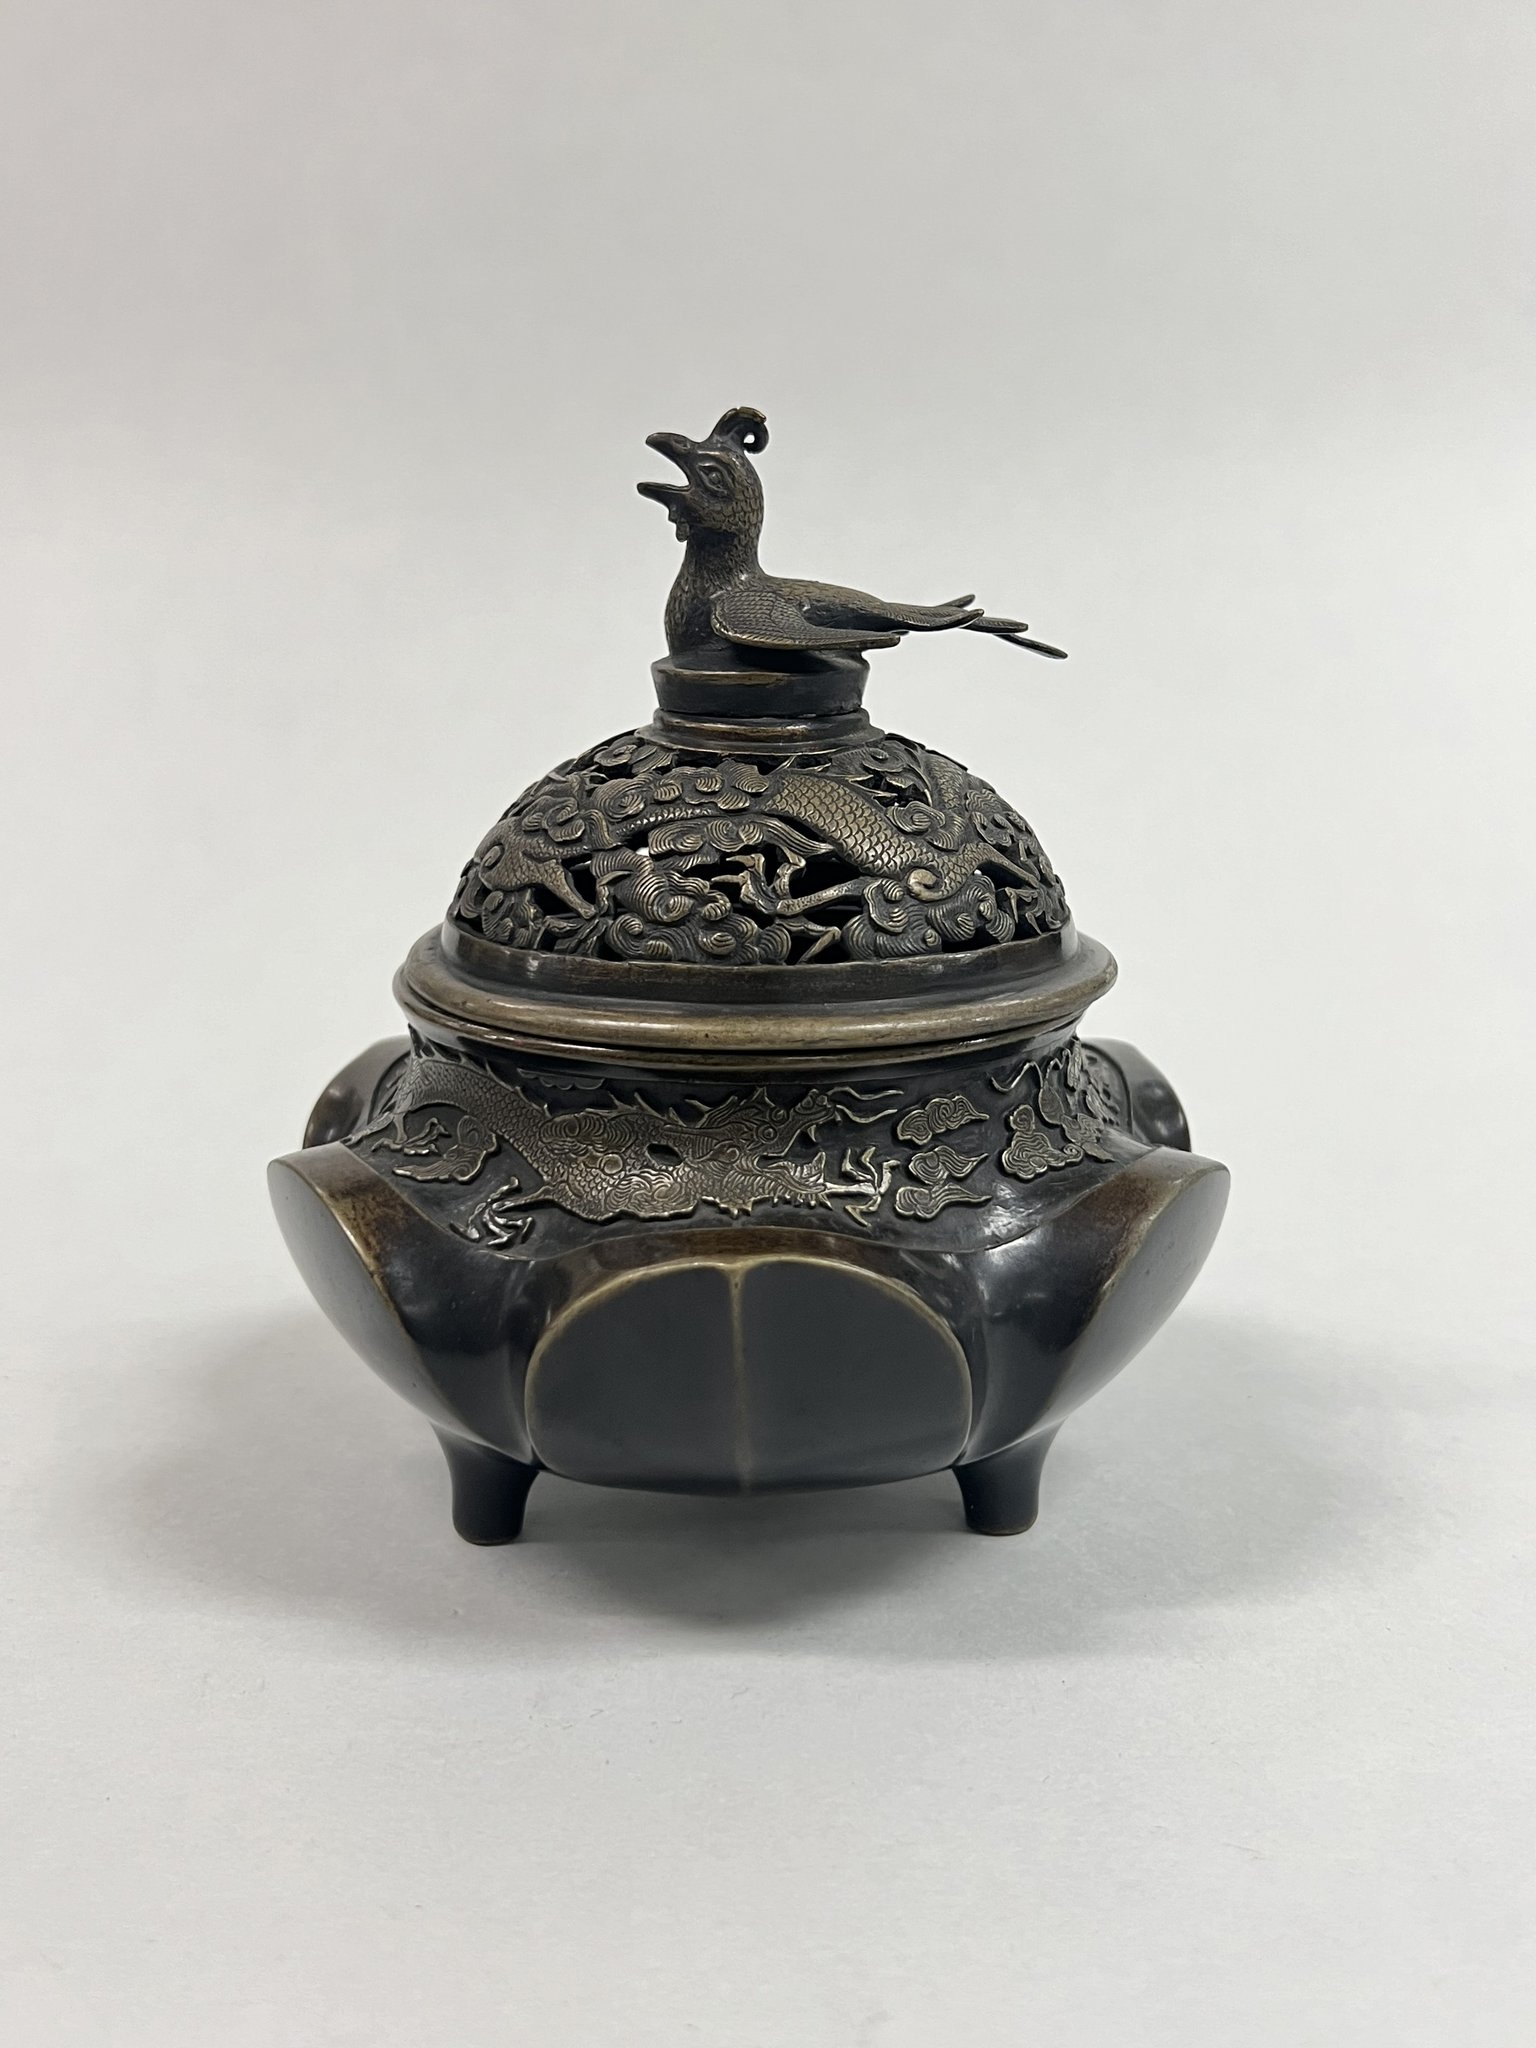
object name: incense bowl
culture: japanese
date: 1734-1900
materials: bronze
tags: birds